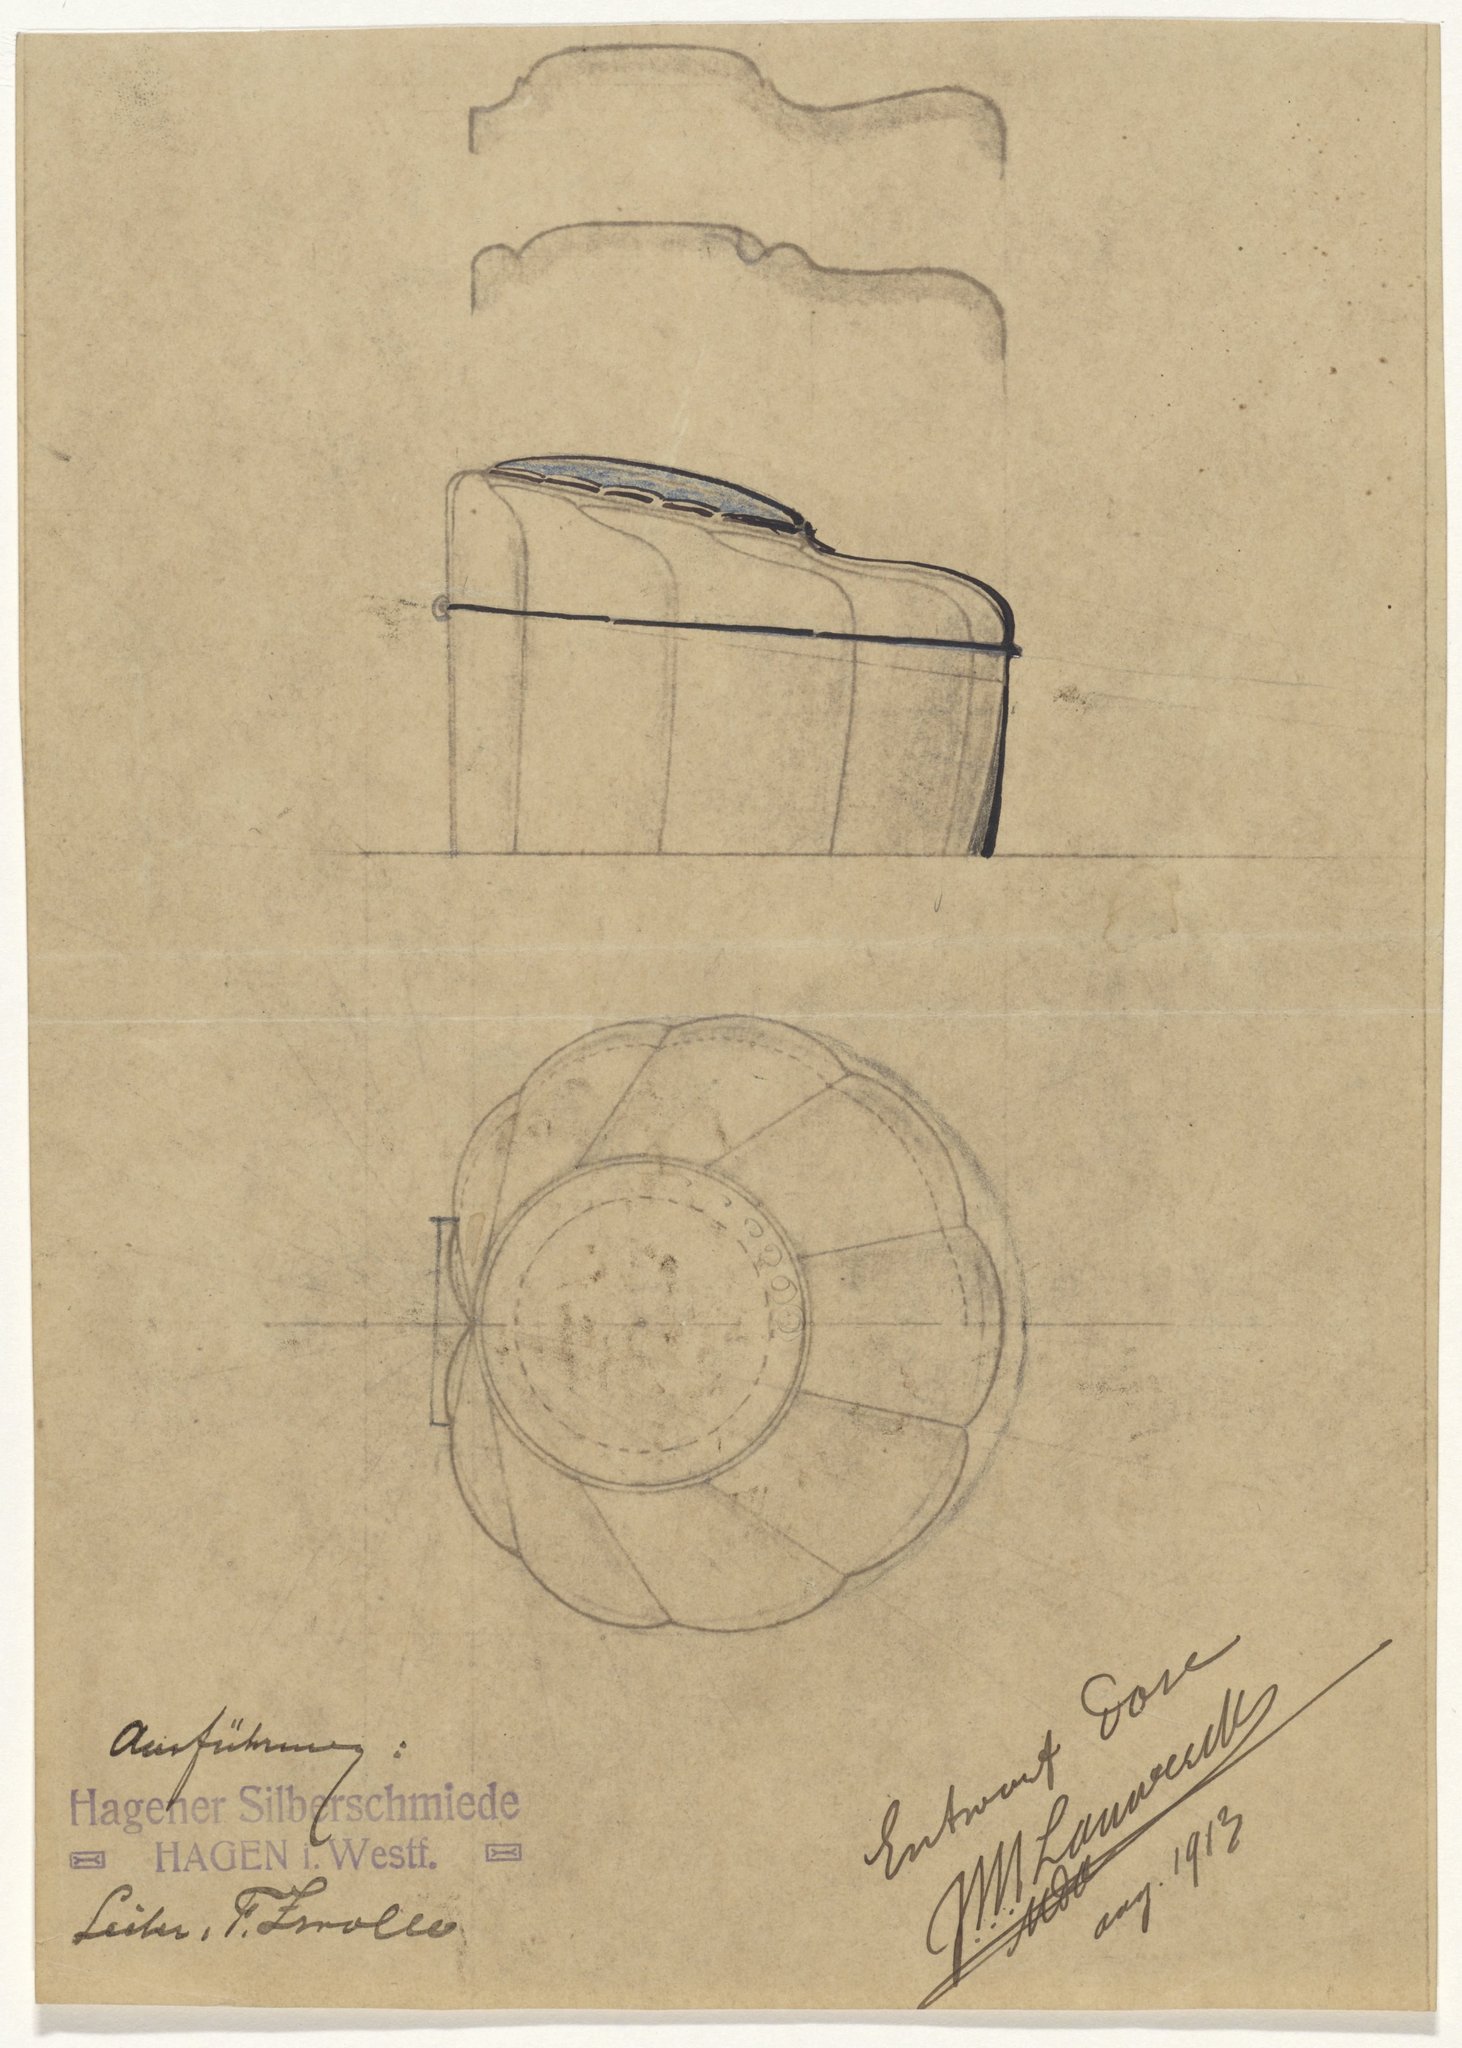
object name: photograph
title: Ontwerpen voor een juwelenkist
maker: mathieu lauweriks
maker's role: designer, draughtsman, print maker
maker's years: 1864-1932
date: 1908-1913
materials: ink, paper, pencil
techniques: blueprint, pen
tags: jewel-box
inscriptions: date: ‘aug 1913’